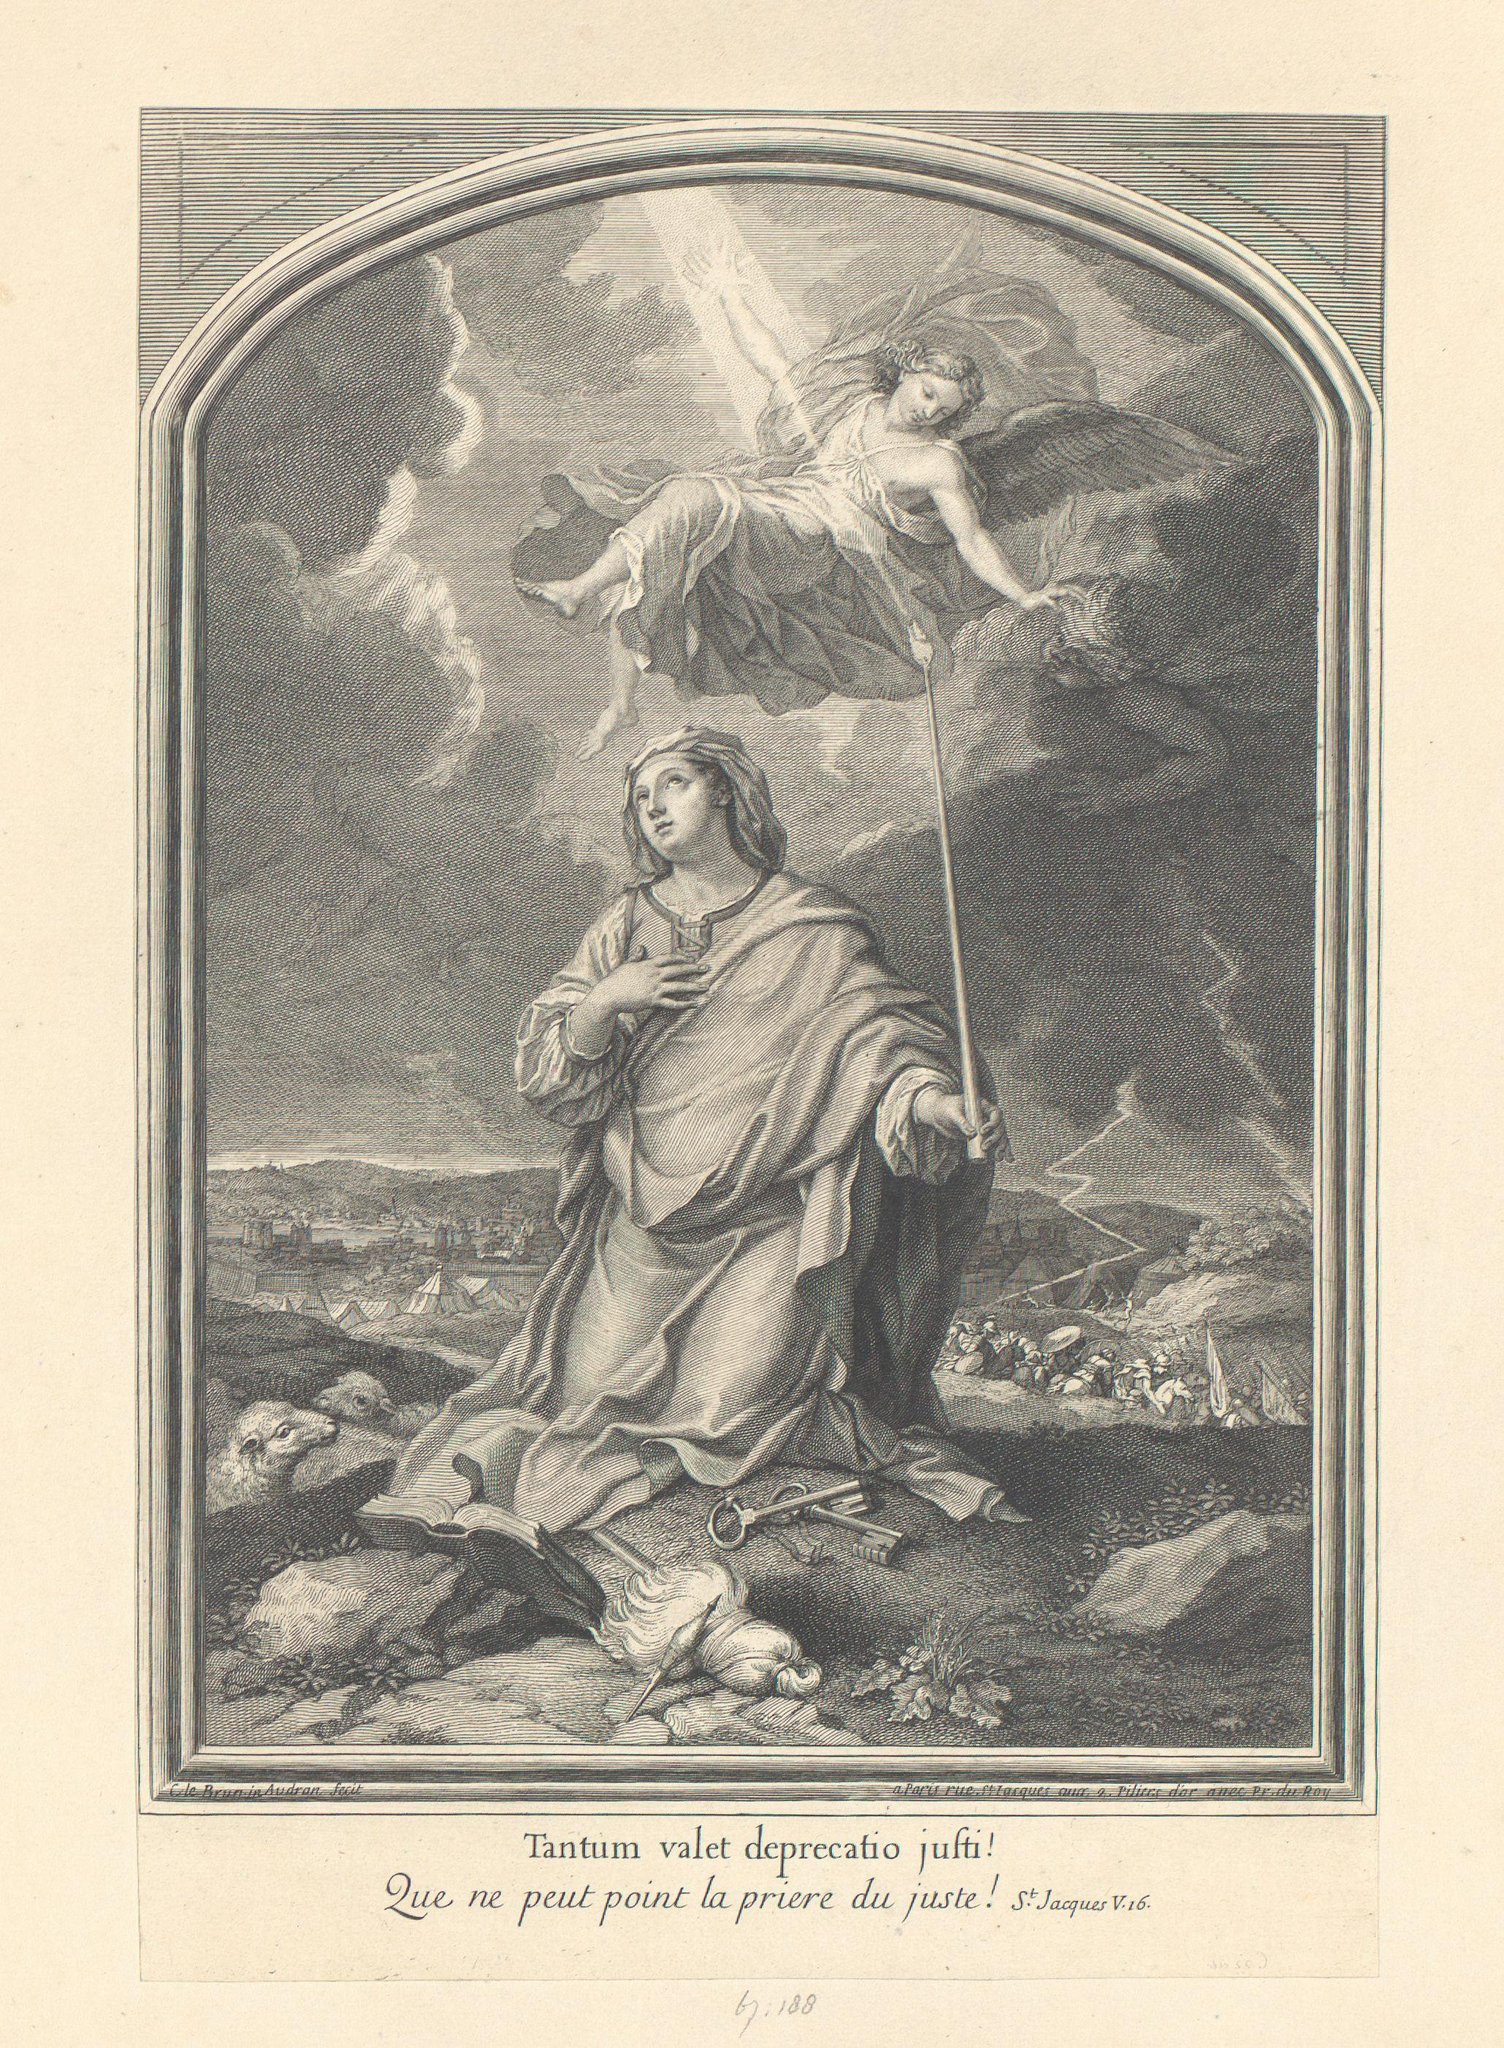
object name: print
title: Werken van Charles le Brun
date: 1671-1721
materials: paper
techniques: engraving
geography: paris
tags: the virgin genevieve (genofeva, genovefa); possible attributes: angel, book, candle (or taper), crown, crook, demon, distaff, medallion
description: Deze prent maakt deel uit van een album.